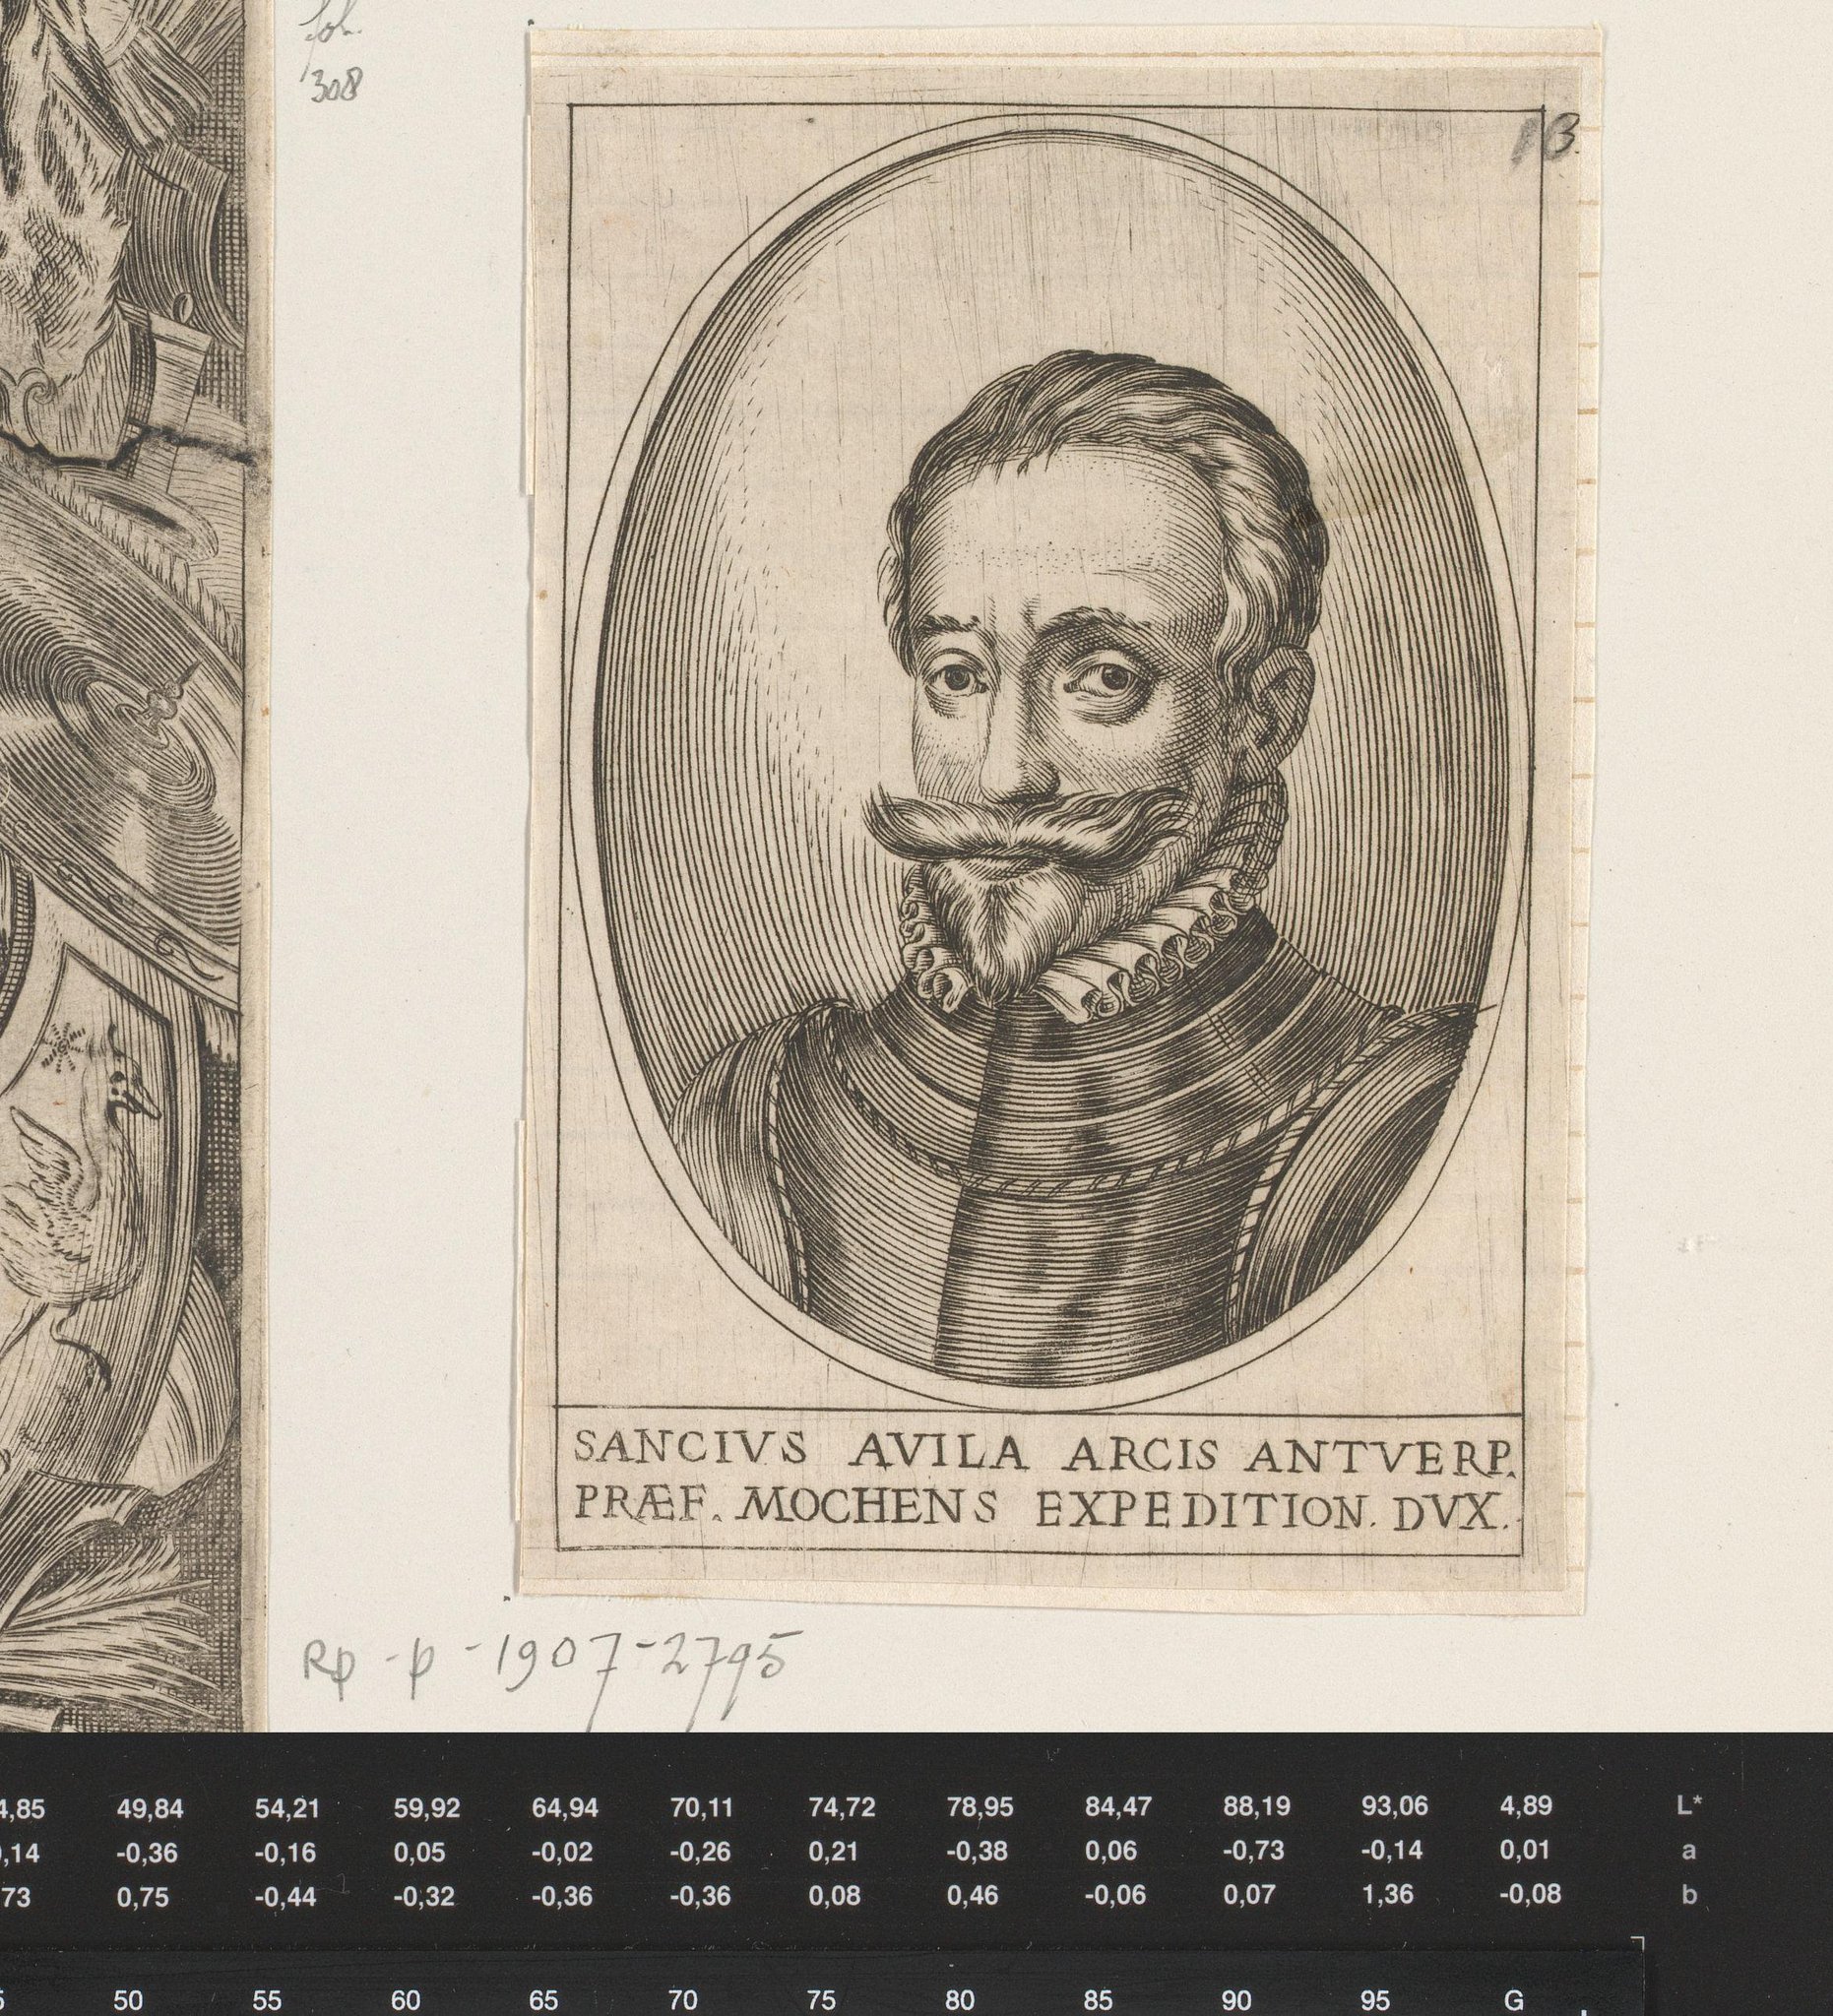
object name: print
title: Portret van Sancho d'Avila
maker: Anonymous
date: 1730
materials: paper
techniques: engraving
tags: ranks in the army, historical persons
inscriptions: collector's mark: Lugt 2228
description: Prent waarschijnlijk uit: Strada, Famiano. De Bello Belgico. Venetië: s.n., 1730, dl. 1, p. 394.